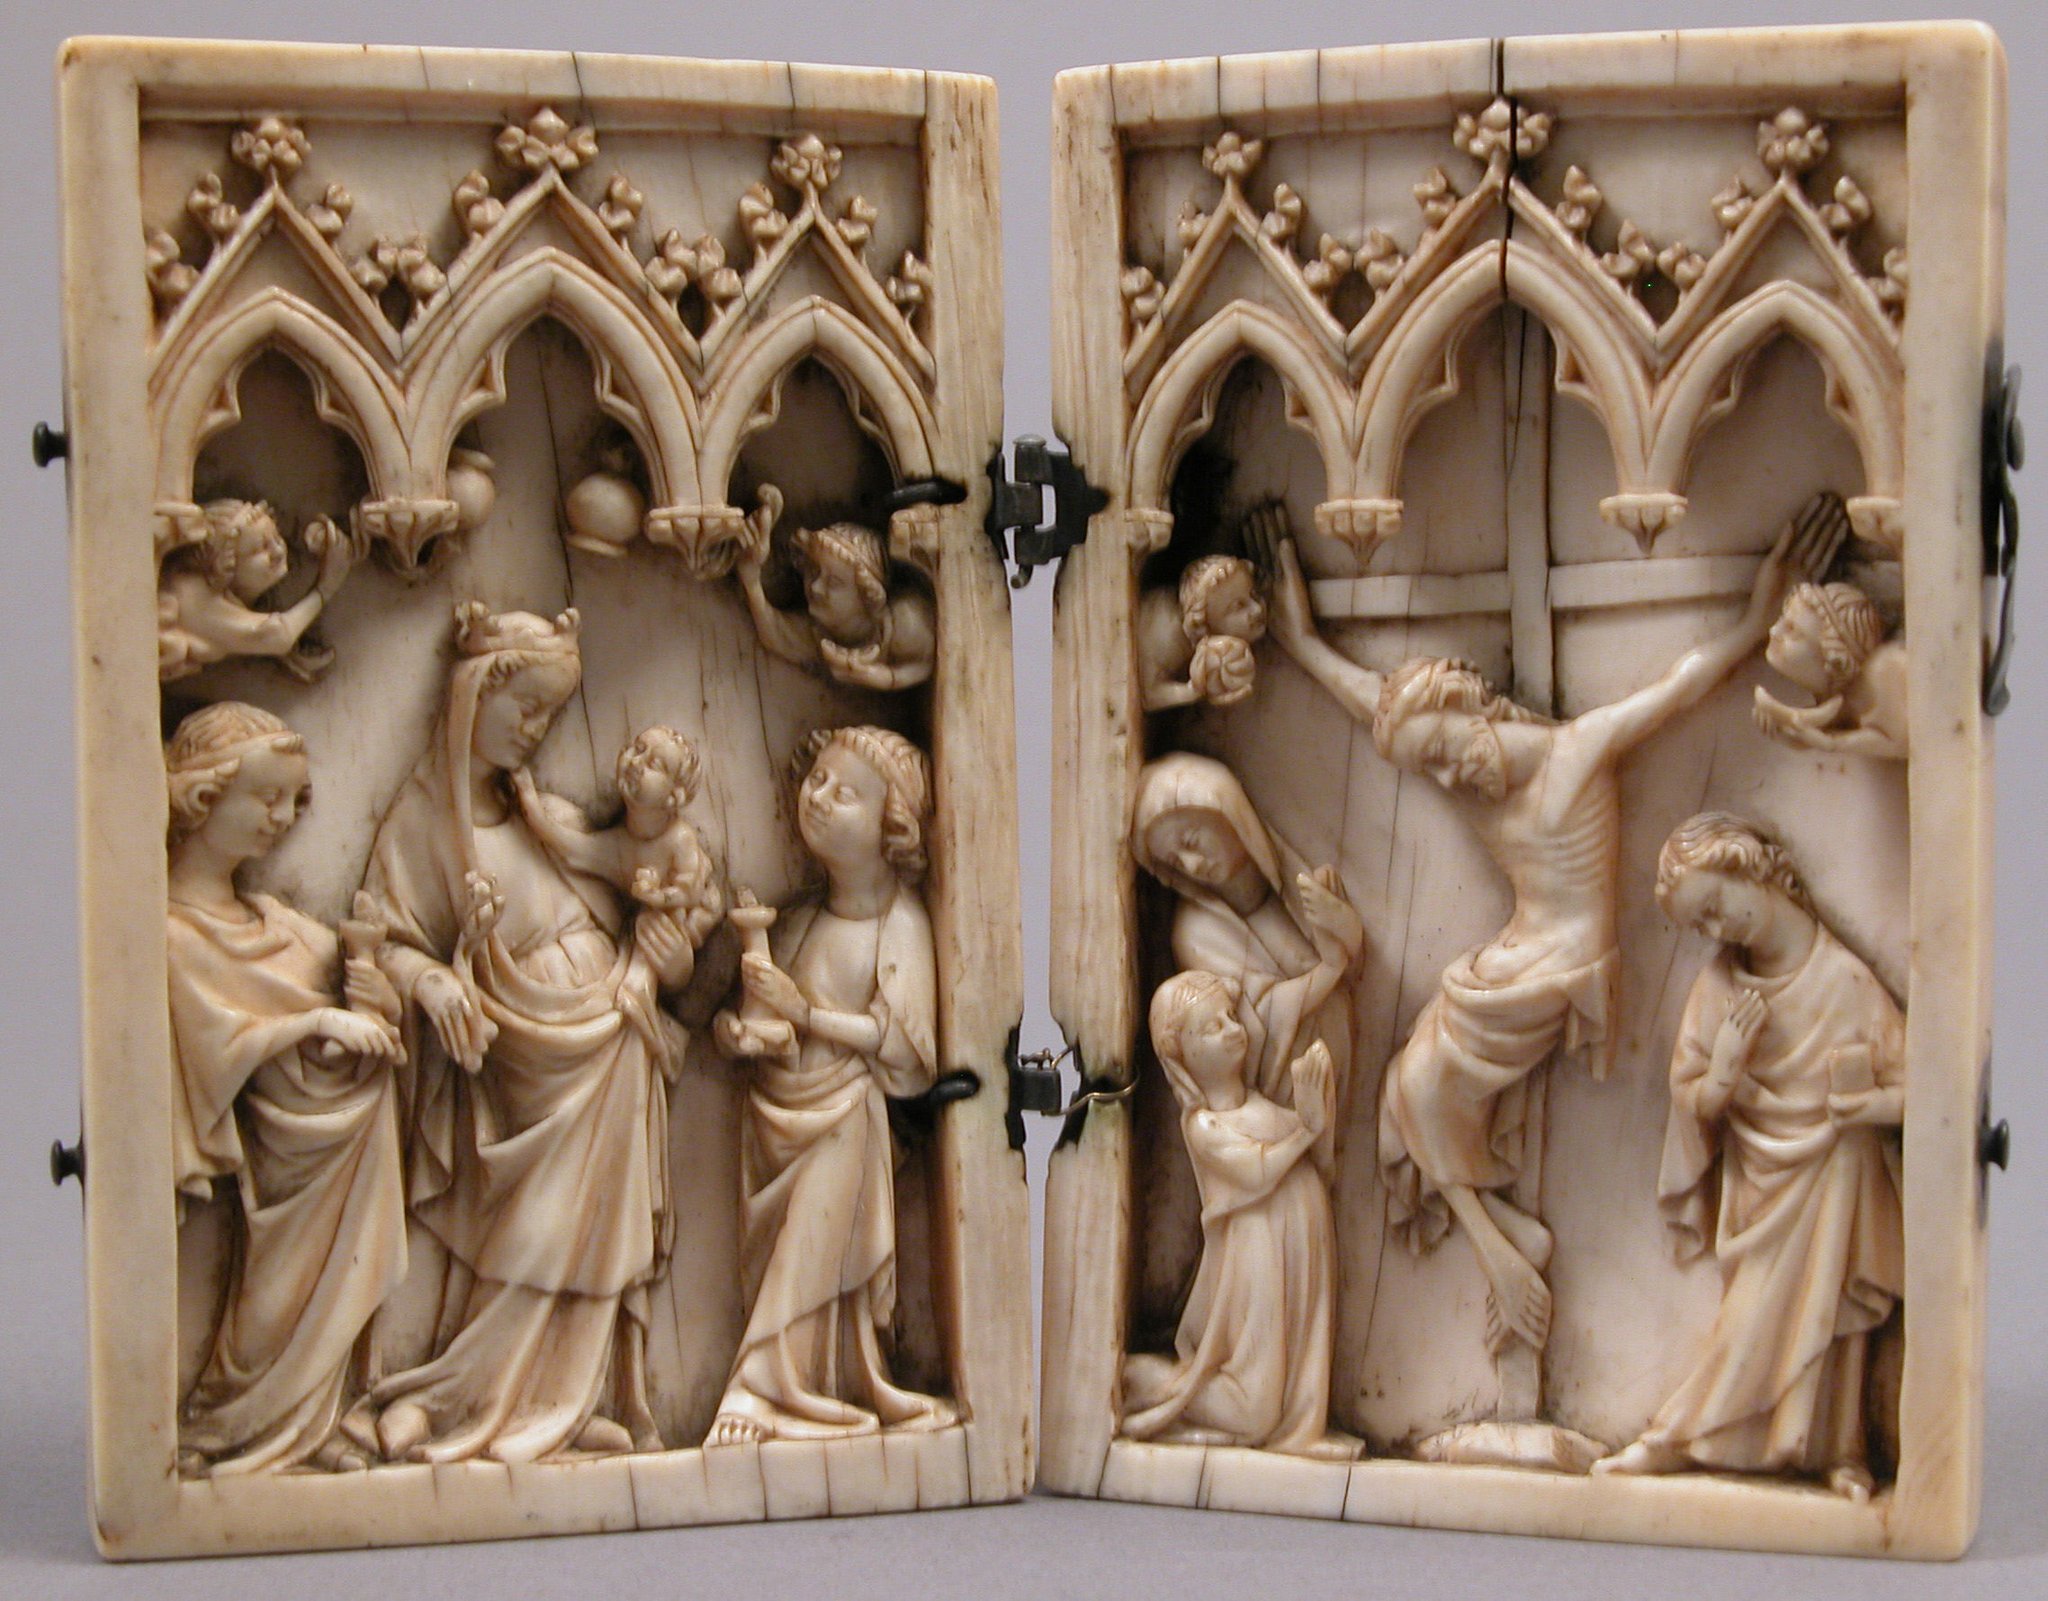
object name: diptych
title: Diptych with the Glorification of the Virgin and the Crucifixion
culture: german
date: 1301-1400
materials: ivory, metal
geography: germany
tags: madonna and child,crucifixion